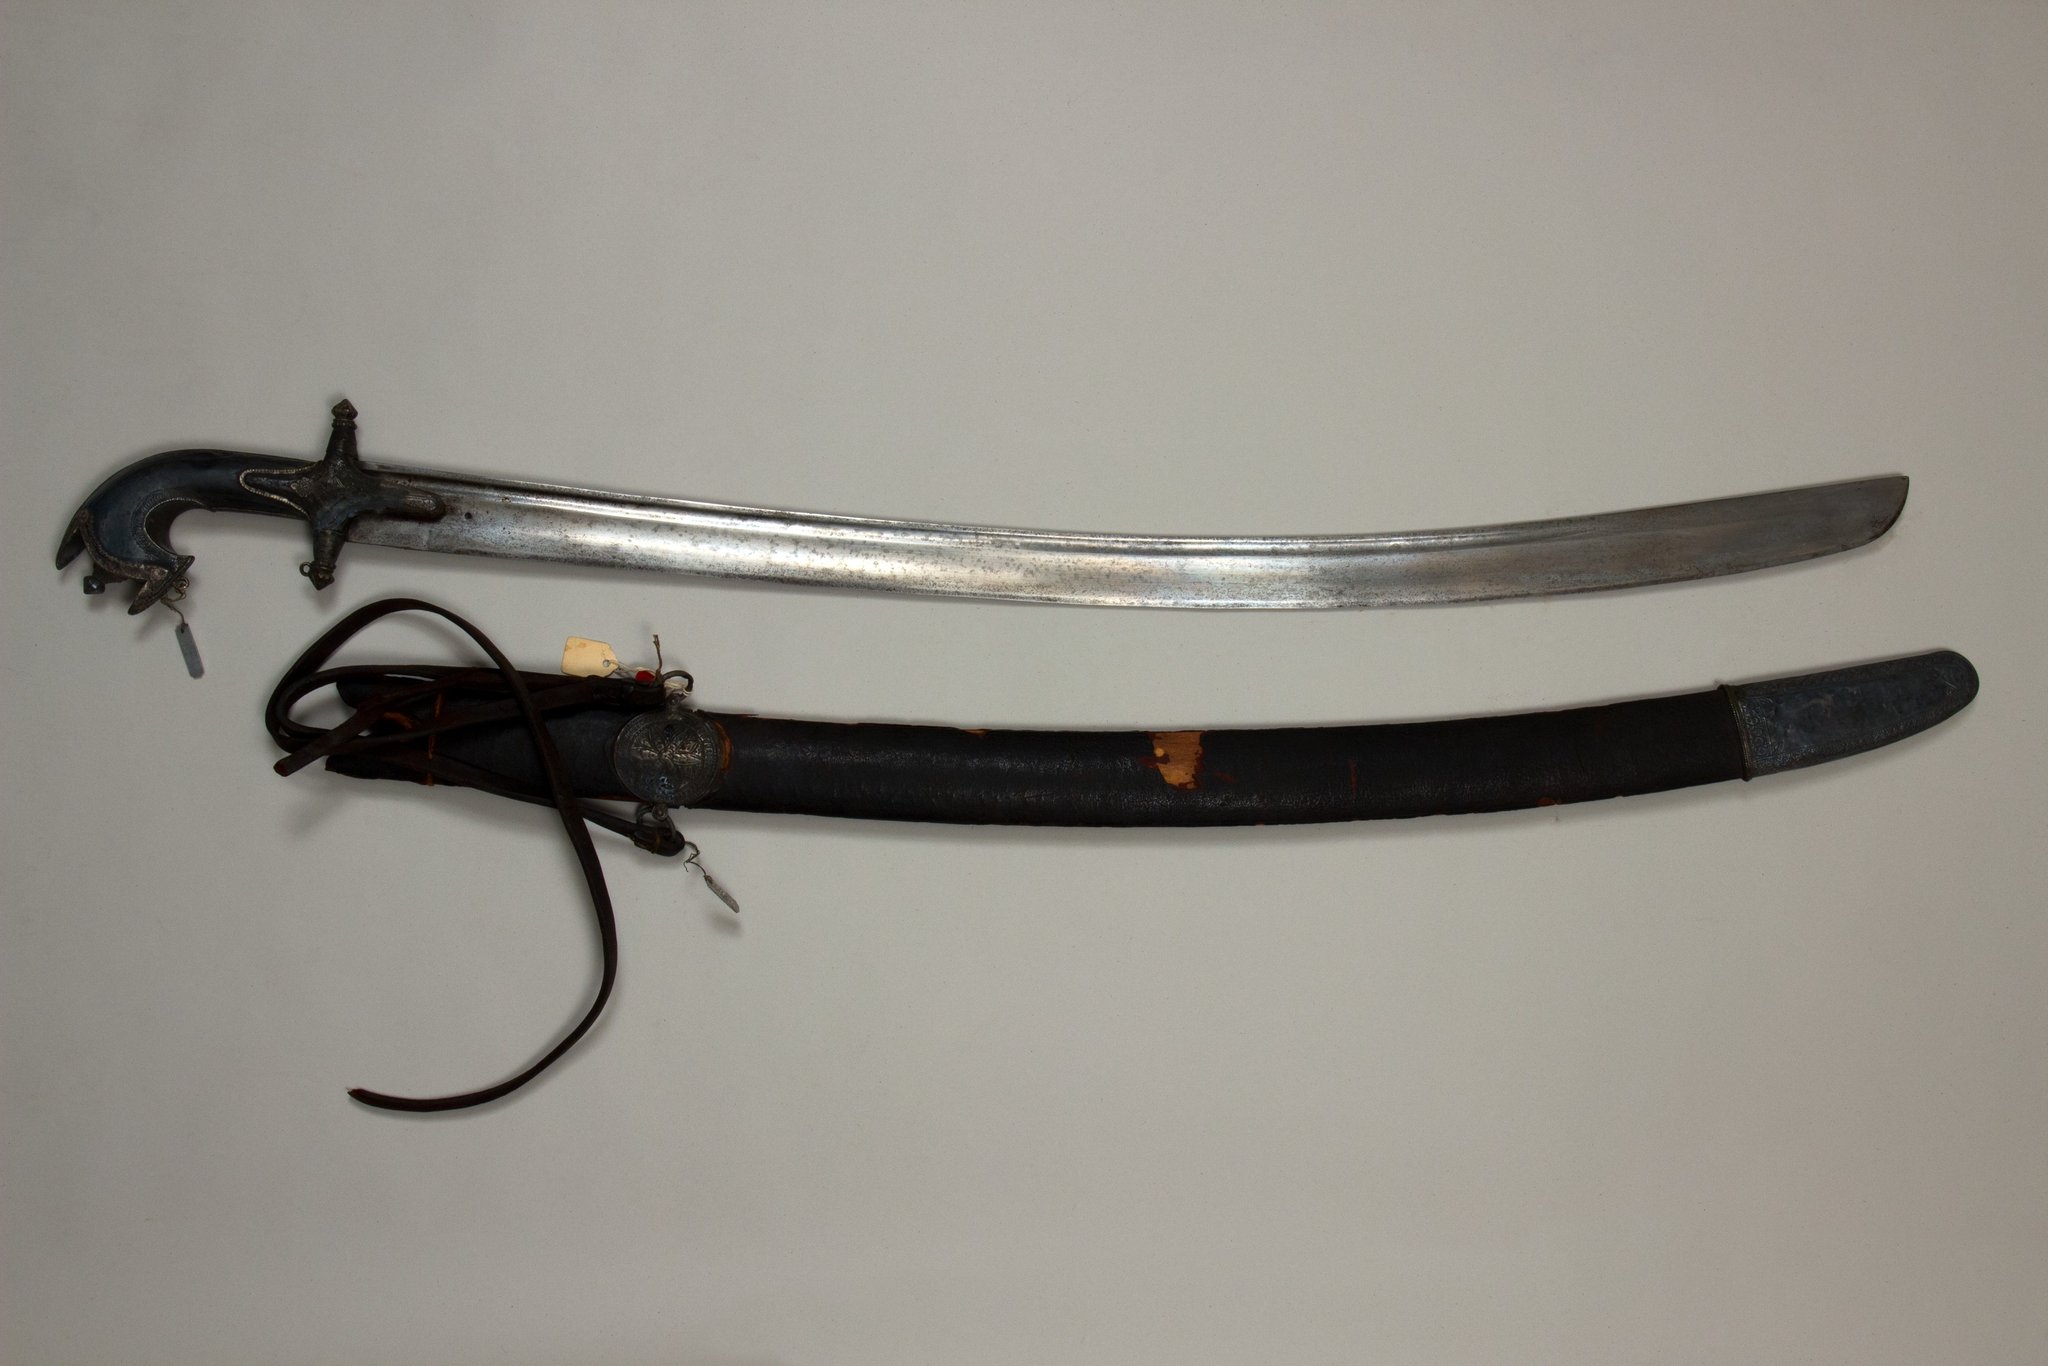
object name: sword saif with scabbard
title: Sword (Saif) with Scabbard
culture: indian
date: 1701-1900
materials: leather, silver, steel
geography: india